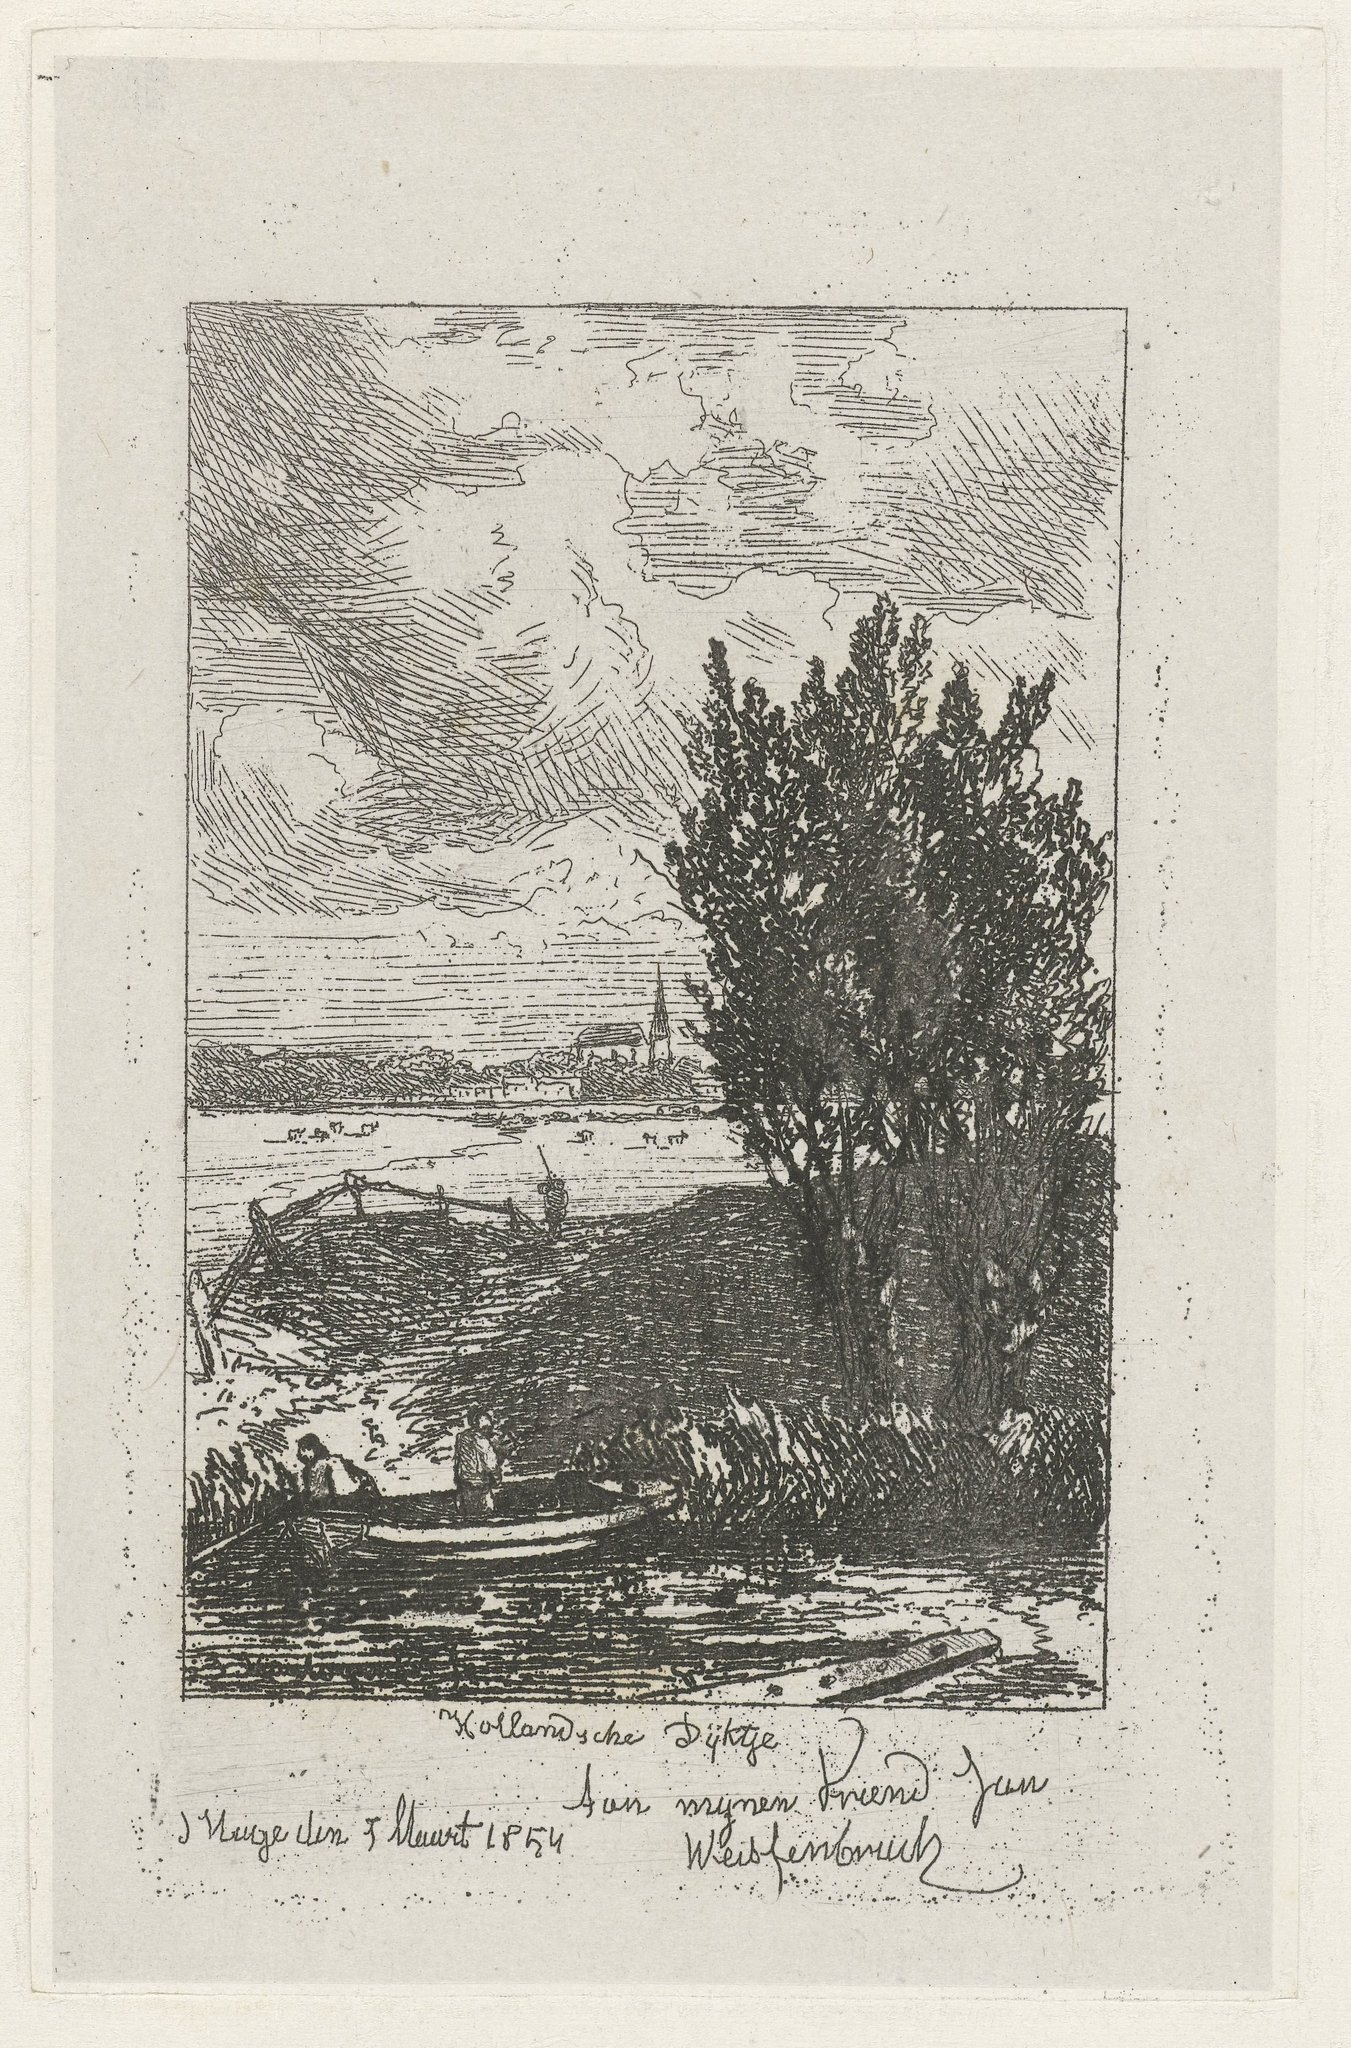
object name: print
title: Weidelandschap met sloot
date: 1854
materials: paper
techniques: etching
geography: the hague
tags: meadow, pasture, water course (+ landscape with figures, staffage)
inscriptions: collector's mark: Lugt 2228, collector's mark: Lugt 138, collector's mark: Lugt 2760